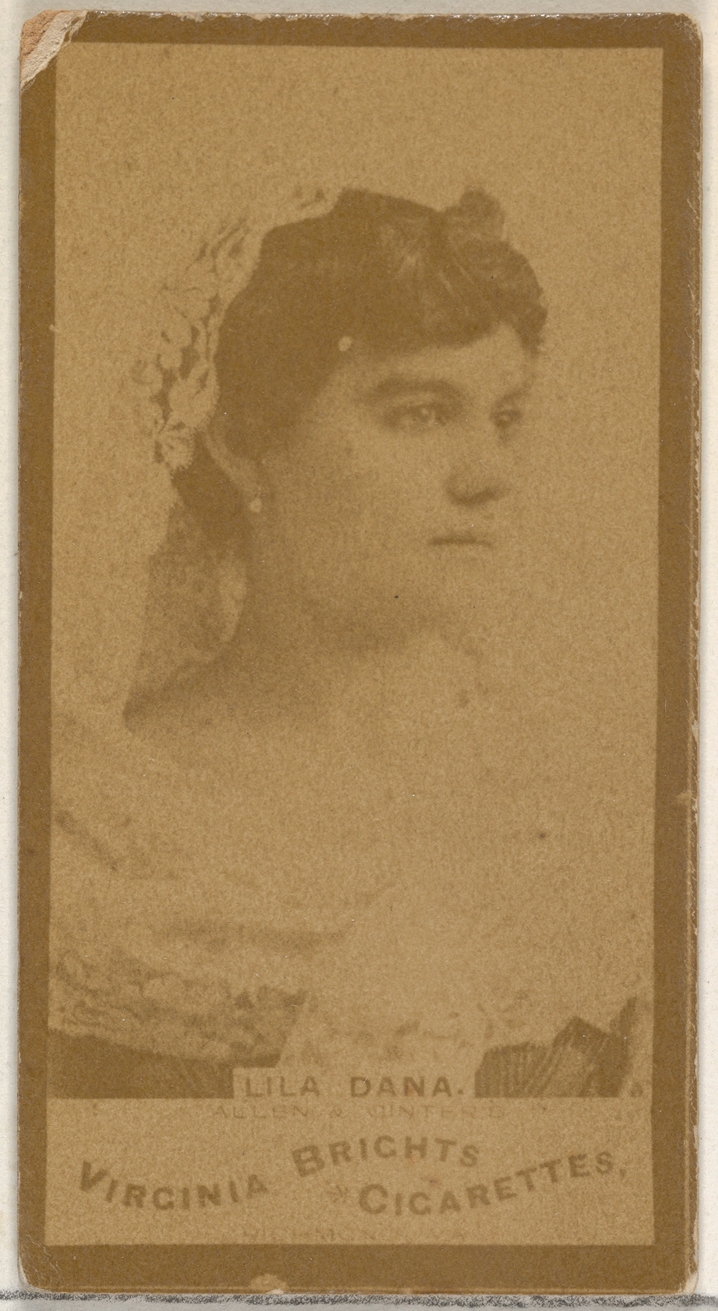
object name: photograph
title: Lila Dana, from the Actors and Actresses series (N45, Type 3) for Virginia Brights Cigarettes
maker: allen & ginter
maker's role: publisher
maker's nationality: american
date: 1888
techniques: albumen silver print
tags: portraits,women,actresses